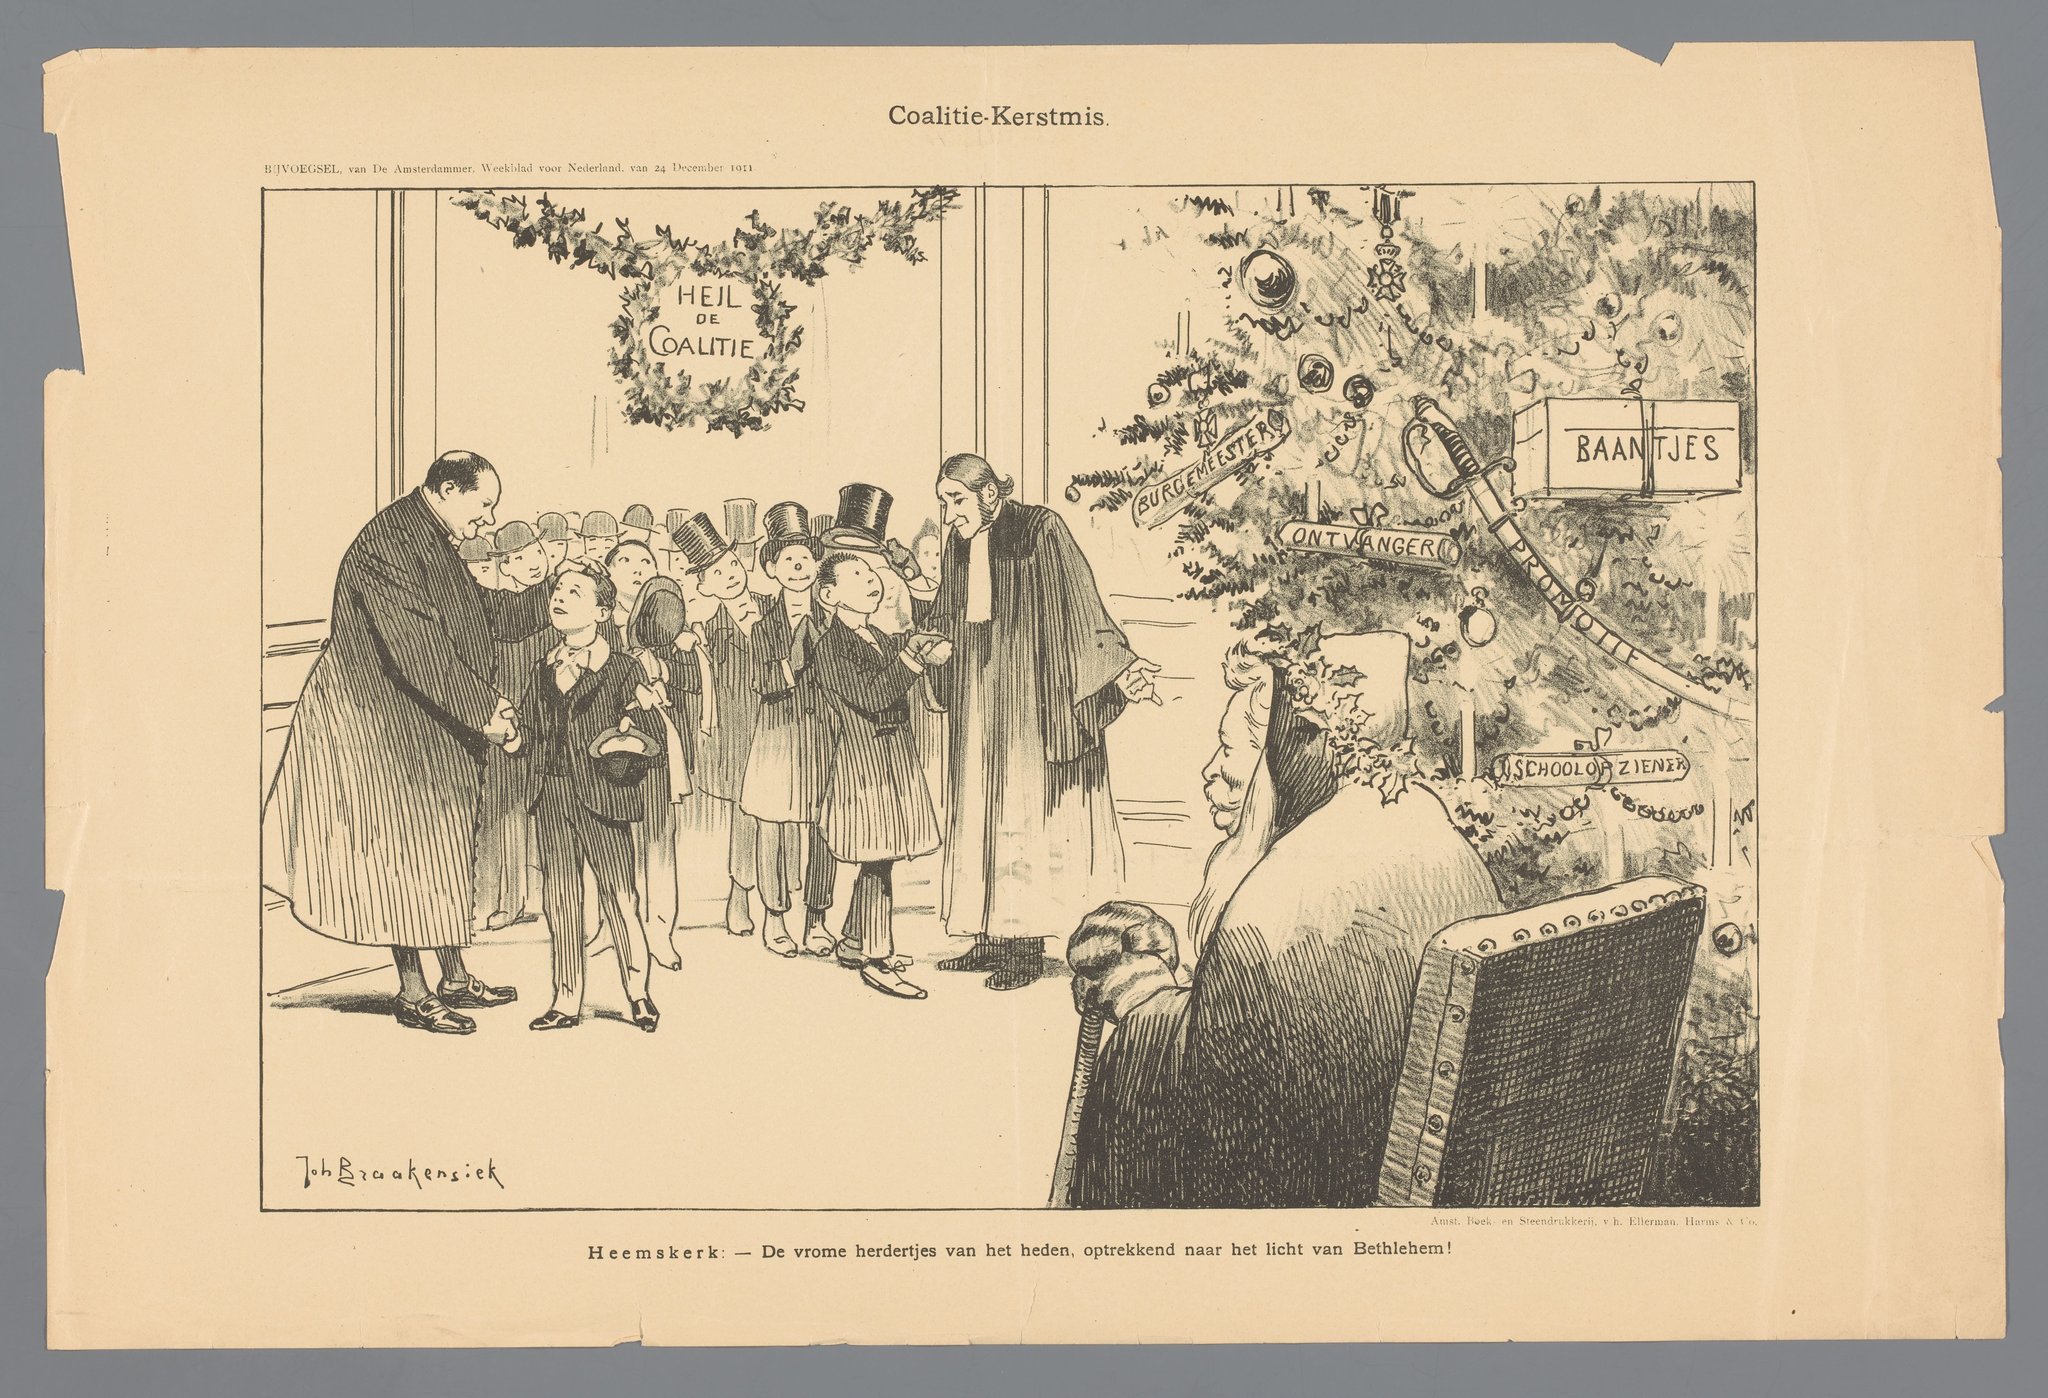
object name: cartoon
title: Coalitie-Kerstmis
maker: johan braakensiek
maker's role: draughtsman, print maker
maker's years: 1858-1940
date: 1911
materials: paper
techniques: lithograph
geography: amsterdam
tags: amsterdam, utrecht, christmas tree, historical persons, political caricatures and satires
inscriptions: date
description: Prent uit het bijvoegsel van: De Amsterdammer. Weekblad voor Nederland, 24 december 1911.